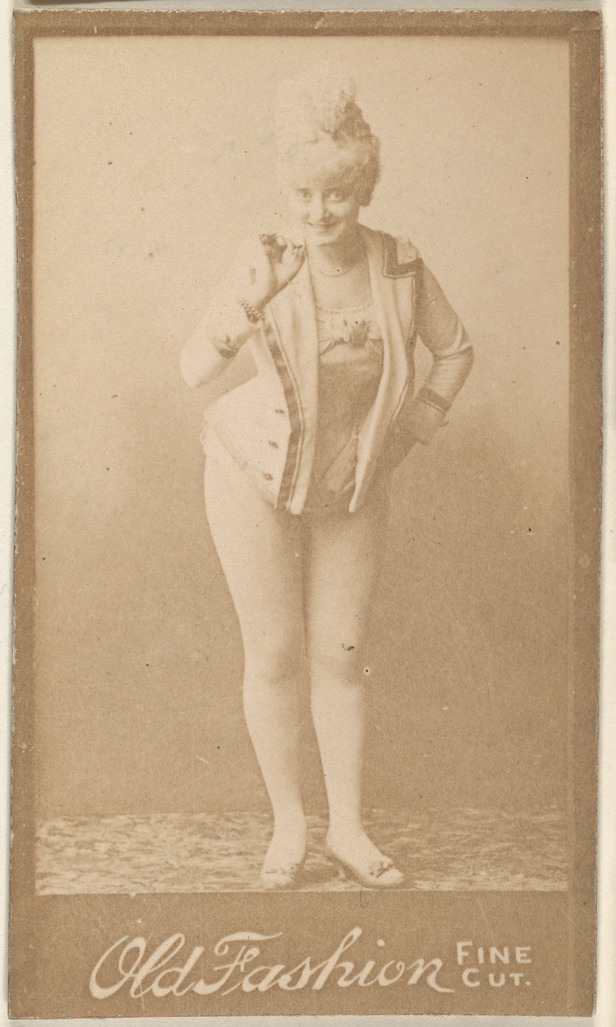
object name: photograph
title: Actress leaning toward camera, from the Actresses series (N664) promoting Old Fashion Fine Cut Tobacco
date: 1888-1890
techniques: albumen silver print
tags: portraits,women,actresses